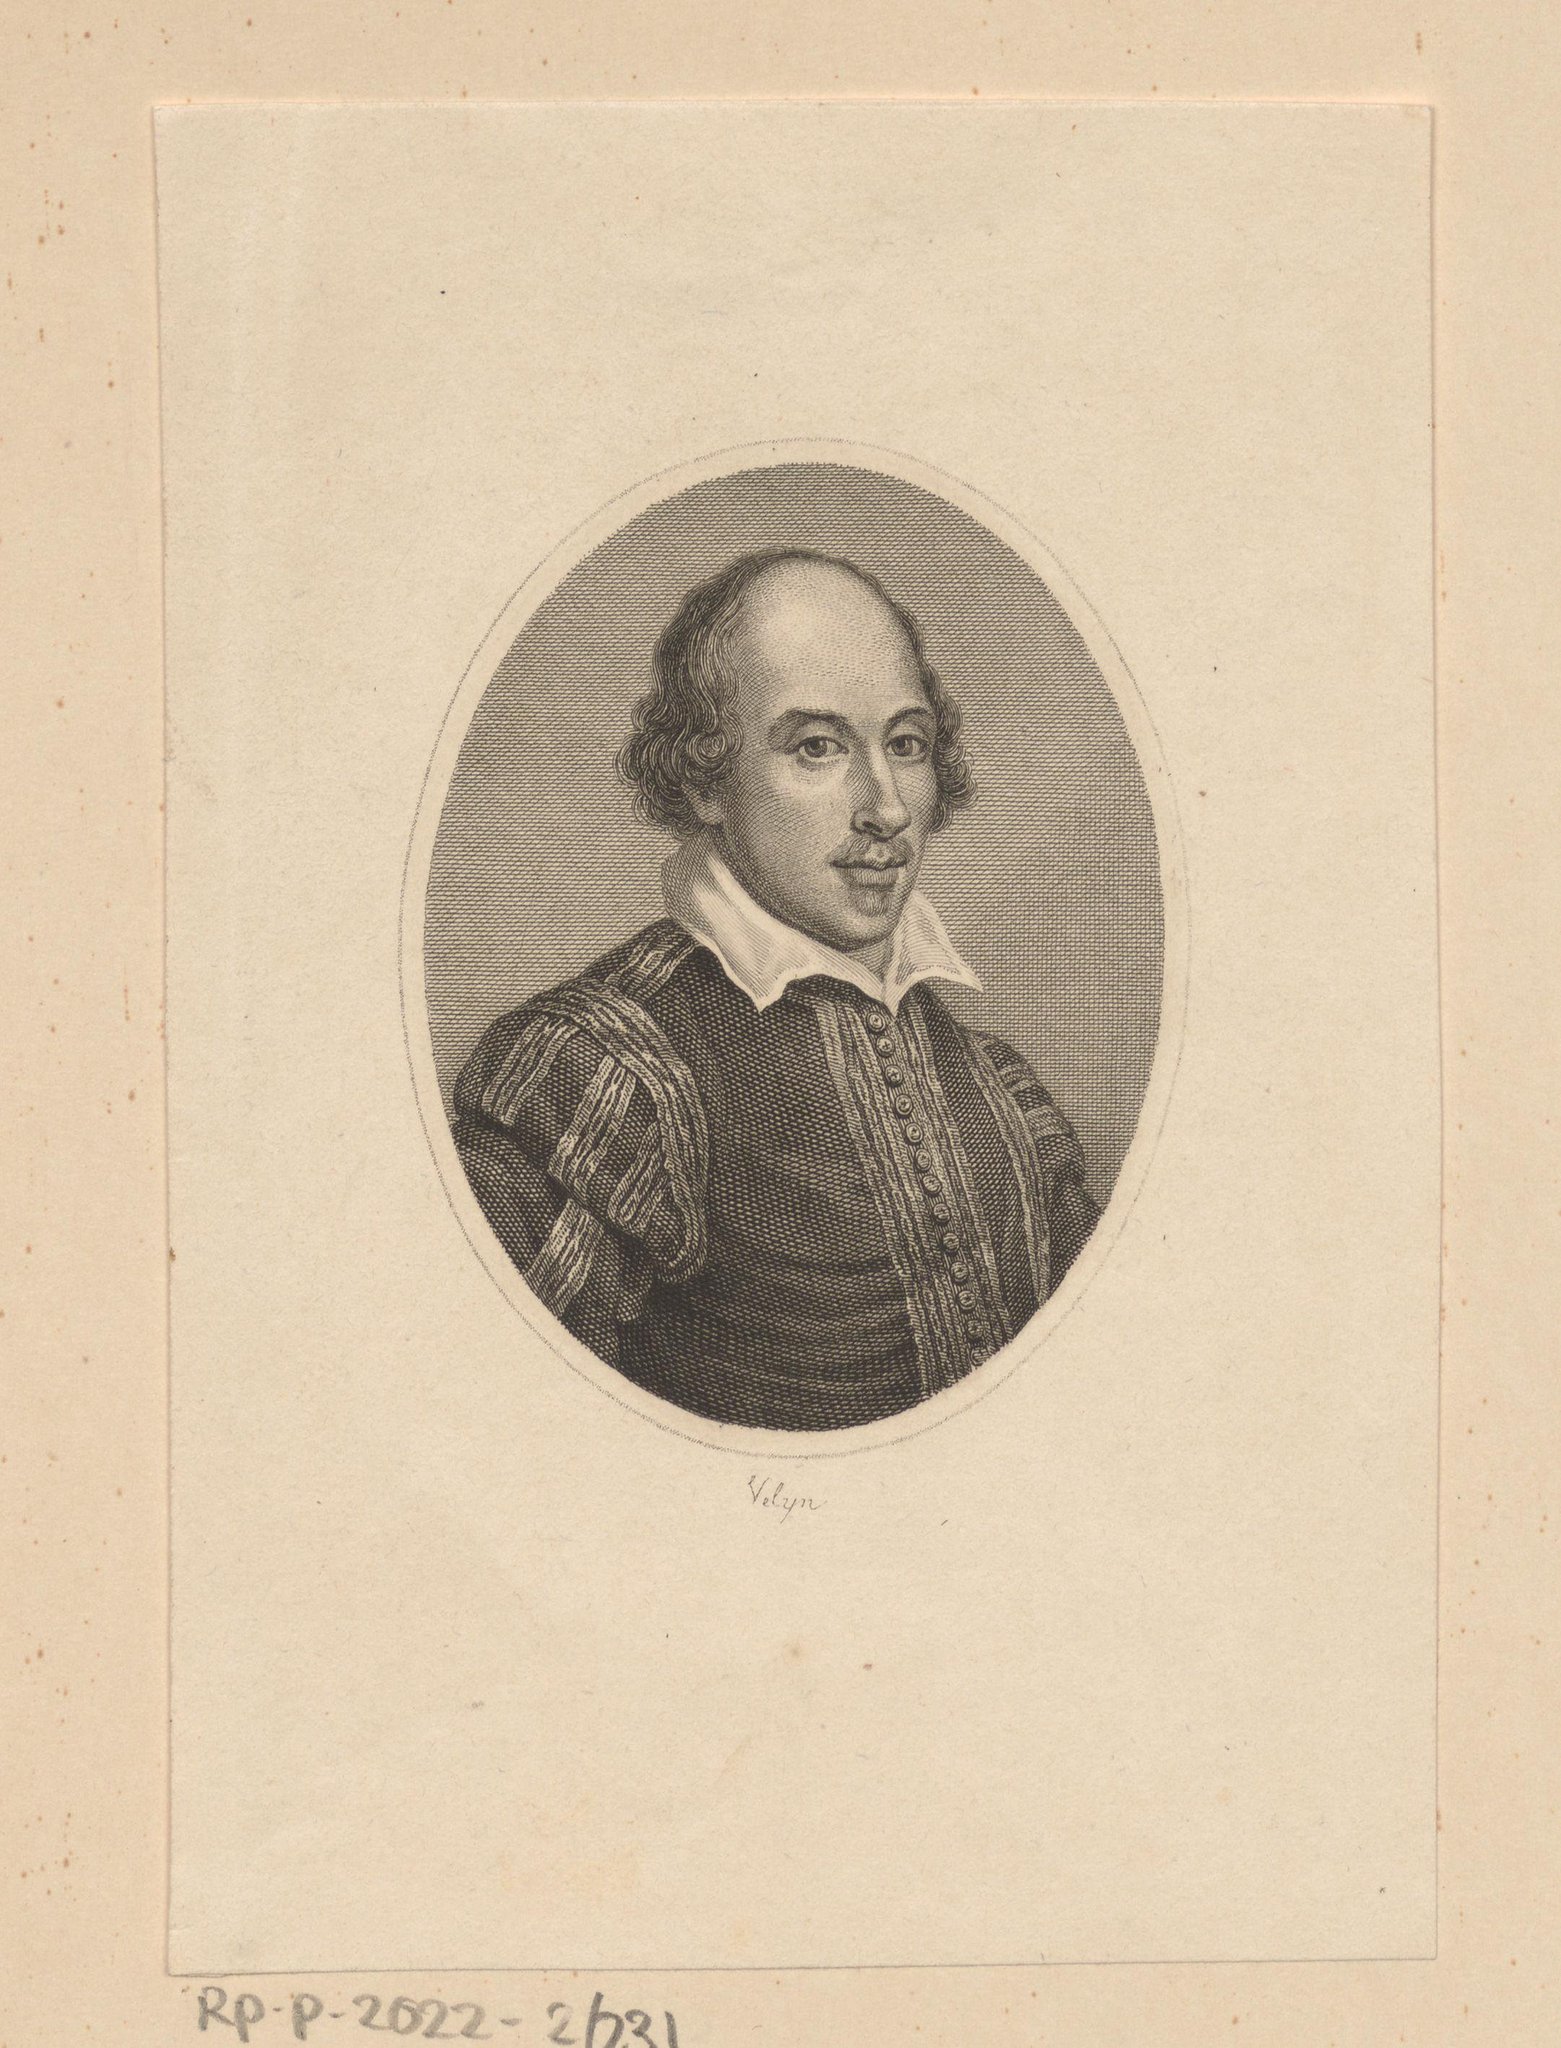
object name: print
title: Portret van William Shakespeare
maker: philippus velijn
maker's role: print maker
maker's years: 1787-1836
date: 1799-1836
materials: paper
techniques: engraving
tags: william shakespeare, historical persons, portrait of a writer